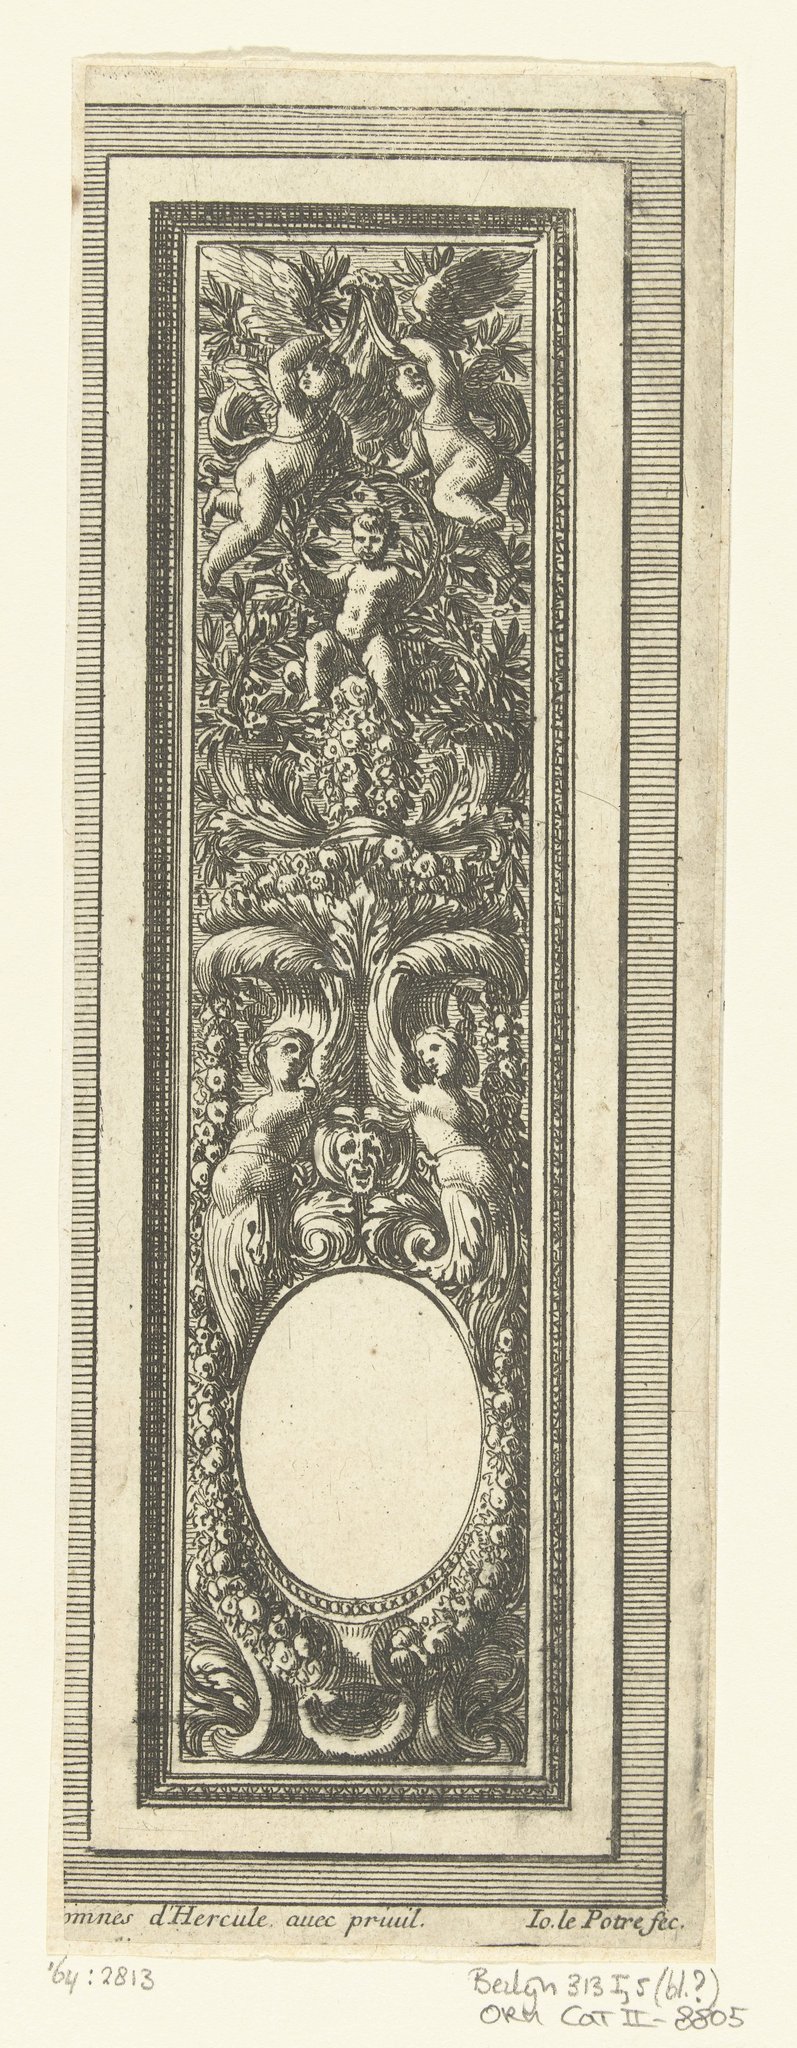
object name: ornament print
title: Frises ou Montans a la moderne seruans pour l'Utilité des Lambris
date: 1657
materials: paper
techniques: etching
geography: france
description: Rechterhelft van blad 4. Uit eerste editie van serie friezen of verticale ornamentele panelen geïnspireerd op kandelabers.